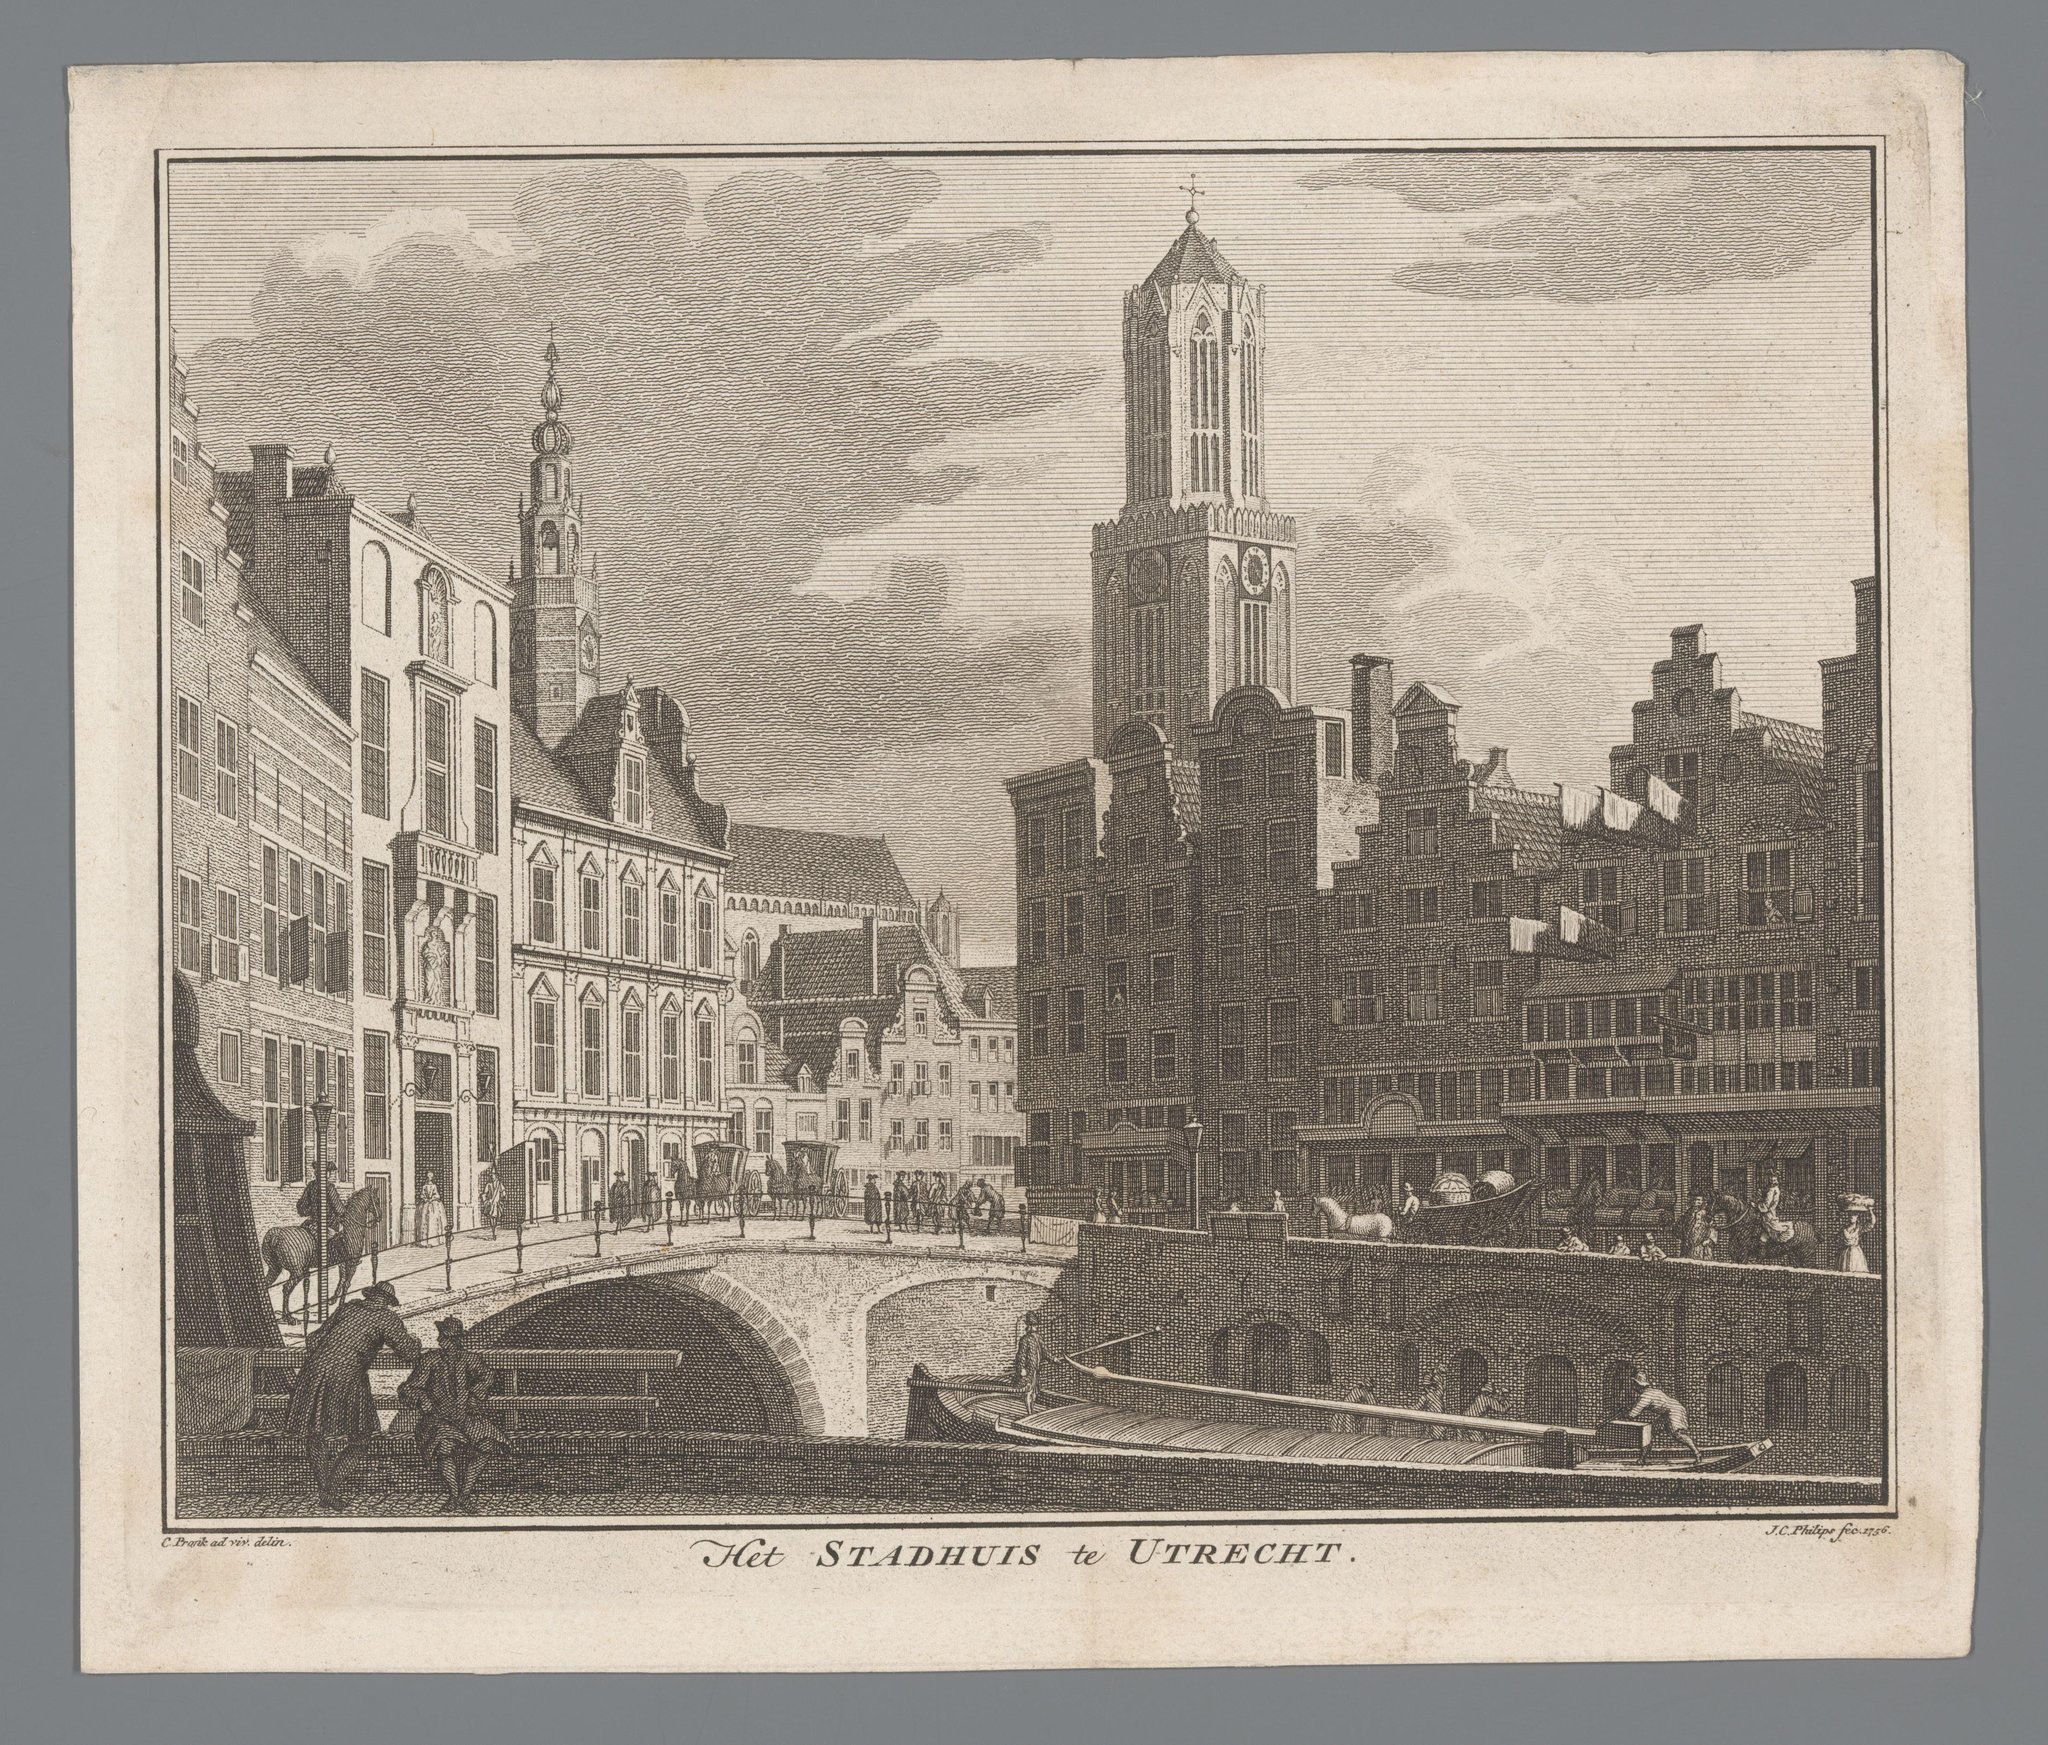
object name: print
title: Het stadhuis te Utrecht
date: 1756-1758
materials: paper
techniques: etching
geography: amsterdam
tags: city-view, and landscape with man-made constructions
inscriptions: collector's mark: Lugt 2233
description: Prent gebruikt in: Tegenwoordige staat der Vereenigde Nederlanden, elfde deel, behelzende eene beschryving van de provincie van Utrecht. Met landkaarten, plans der steden en printverbeeldingen versierd / Hedendaagsche historie, of tegenwoordige staat van alle volkeren; XXI. deel (…). Amsterdam: Isaak Tirion, 1758, tussen p. 352 en 353.